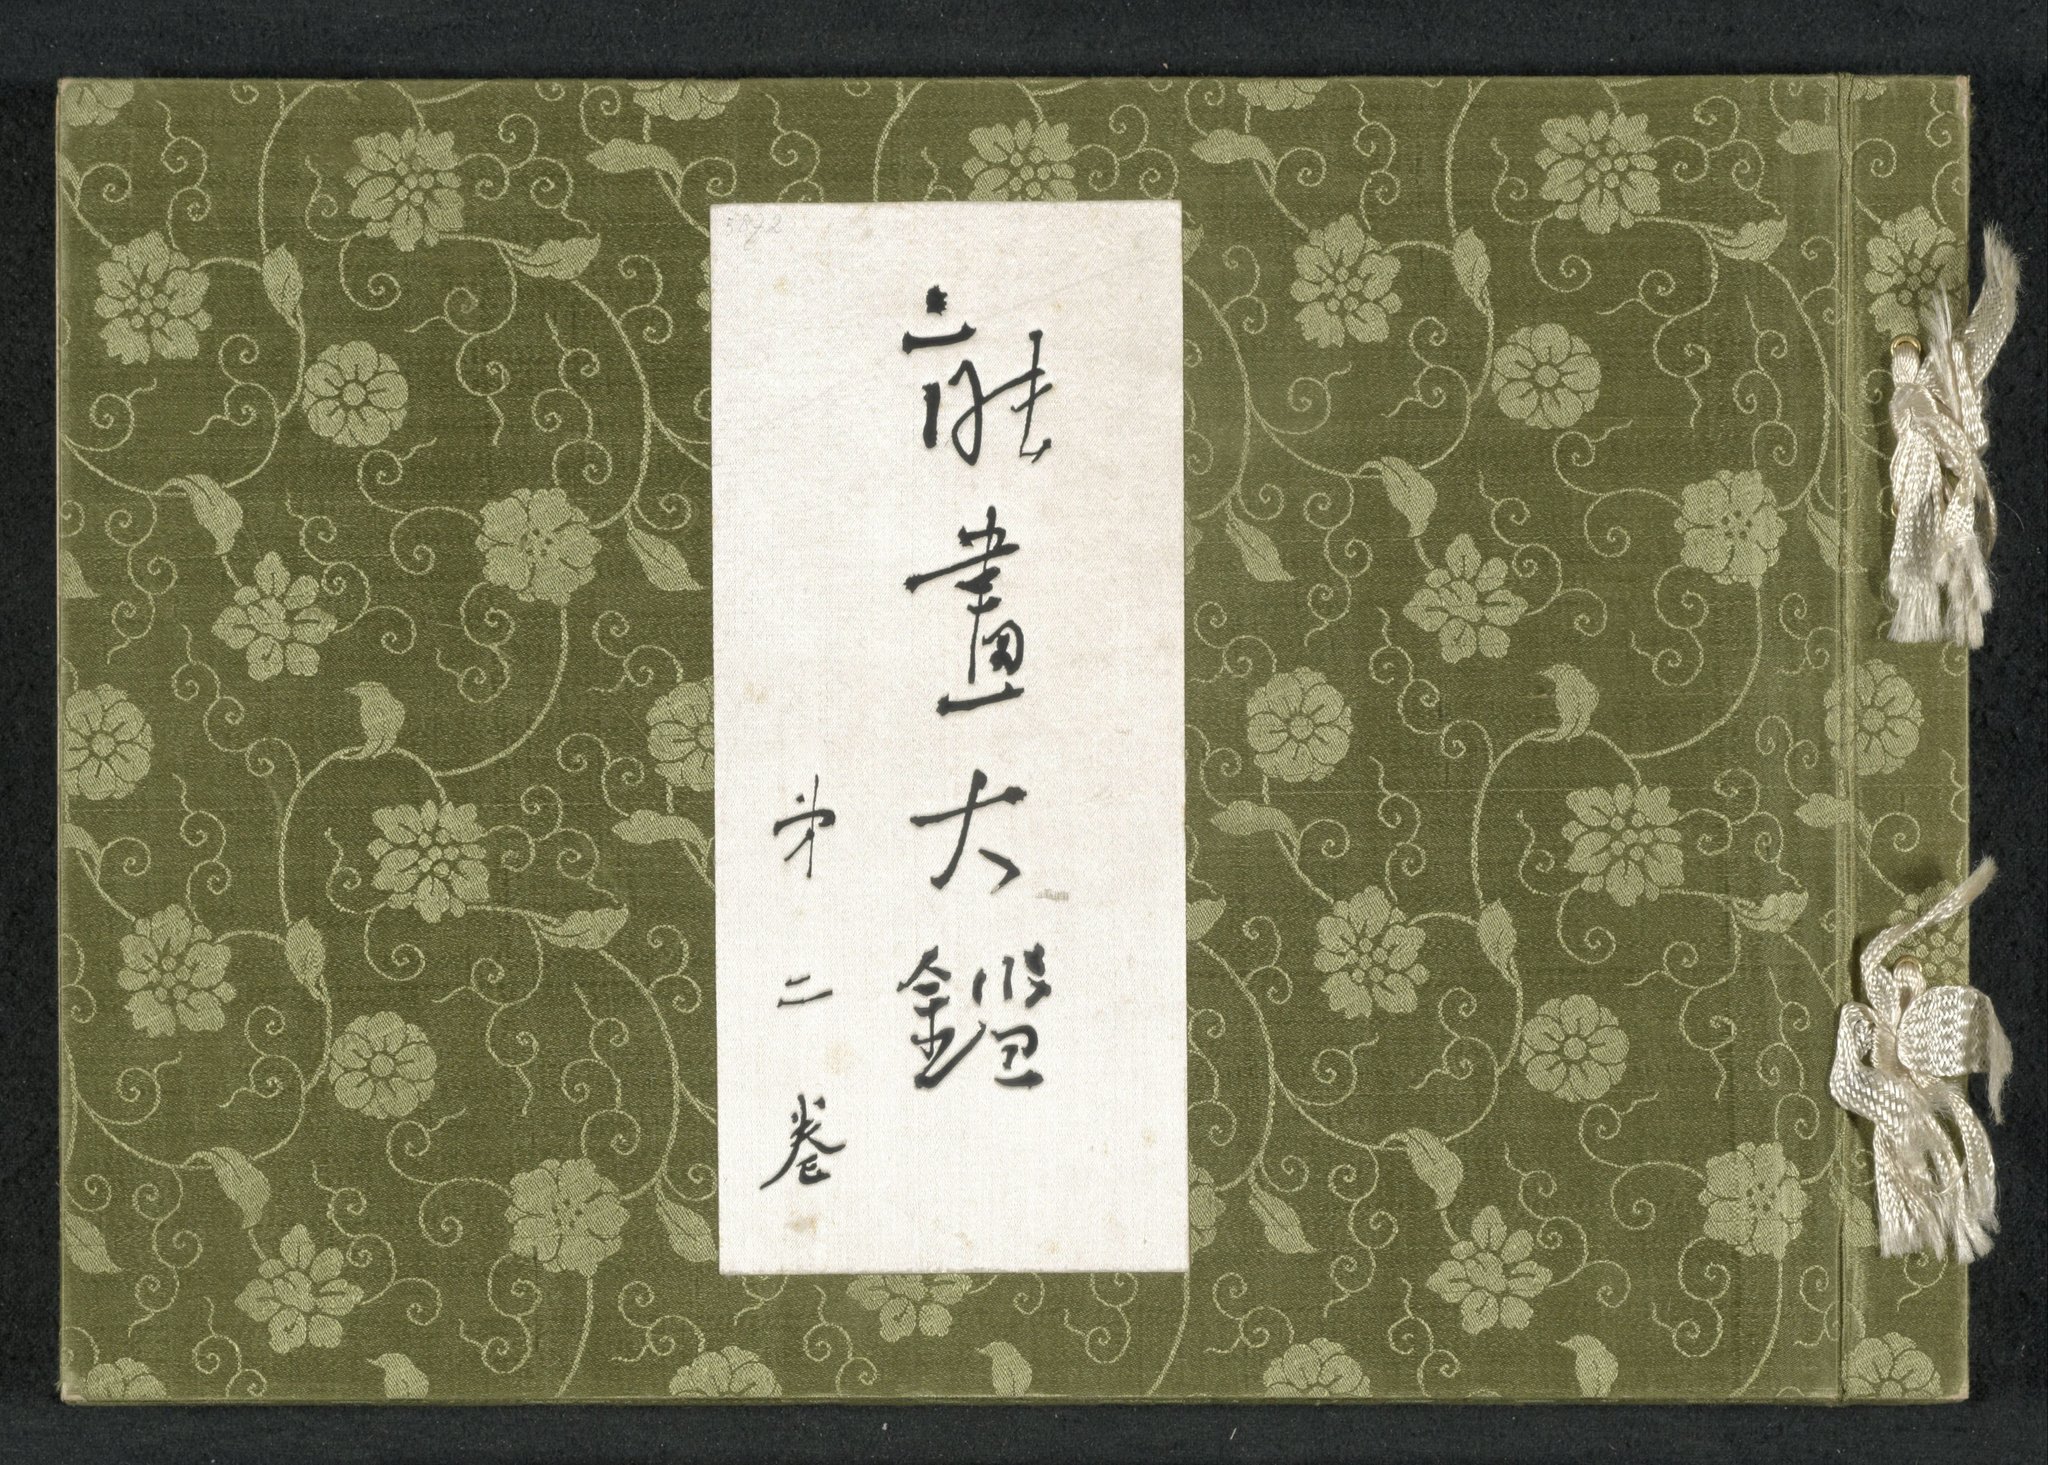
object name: picture book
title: Nôga taikan dai san maki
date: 1925-1926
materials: cardboard, paper, ribbon, silk, textile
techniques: woodcut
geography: japan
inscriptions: collector's mark: ‘Rijks-Ethnographisch Museum’